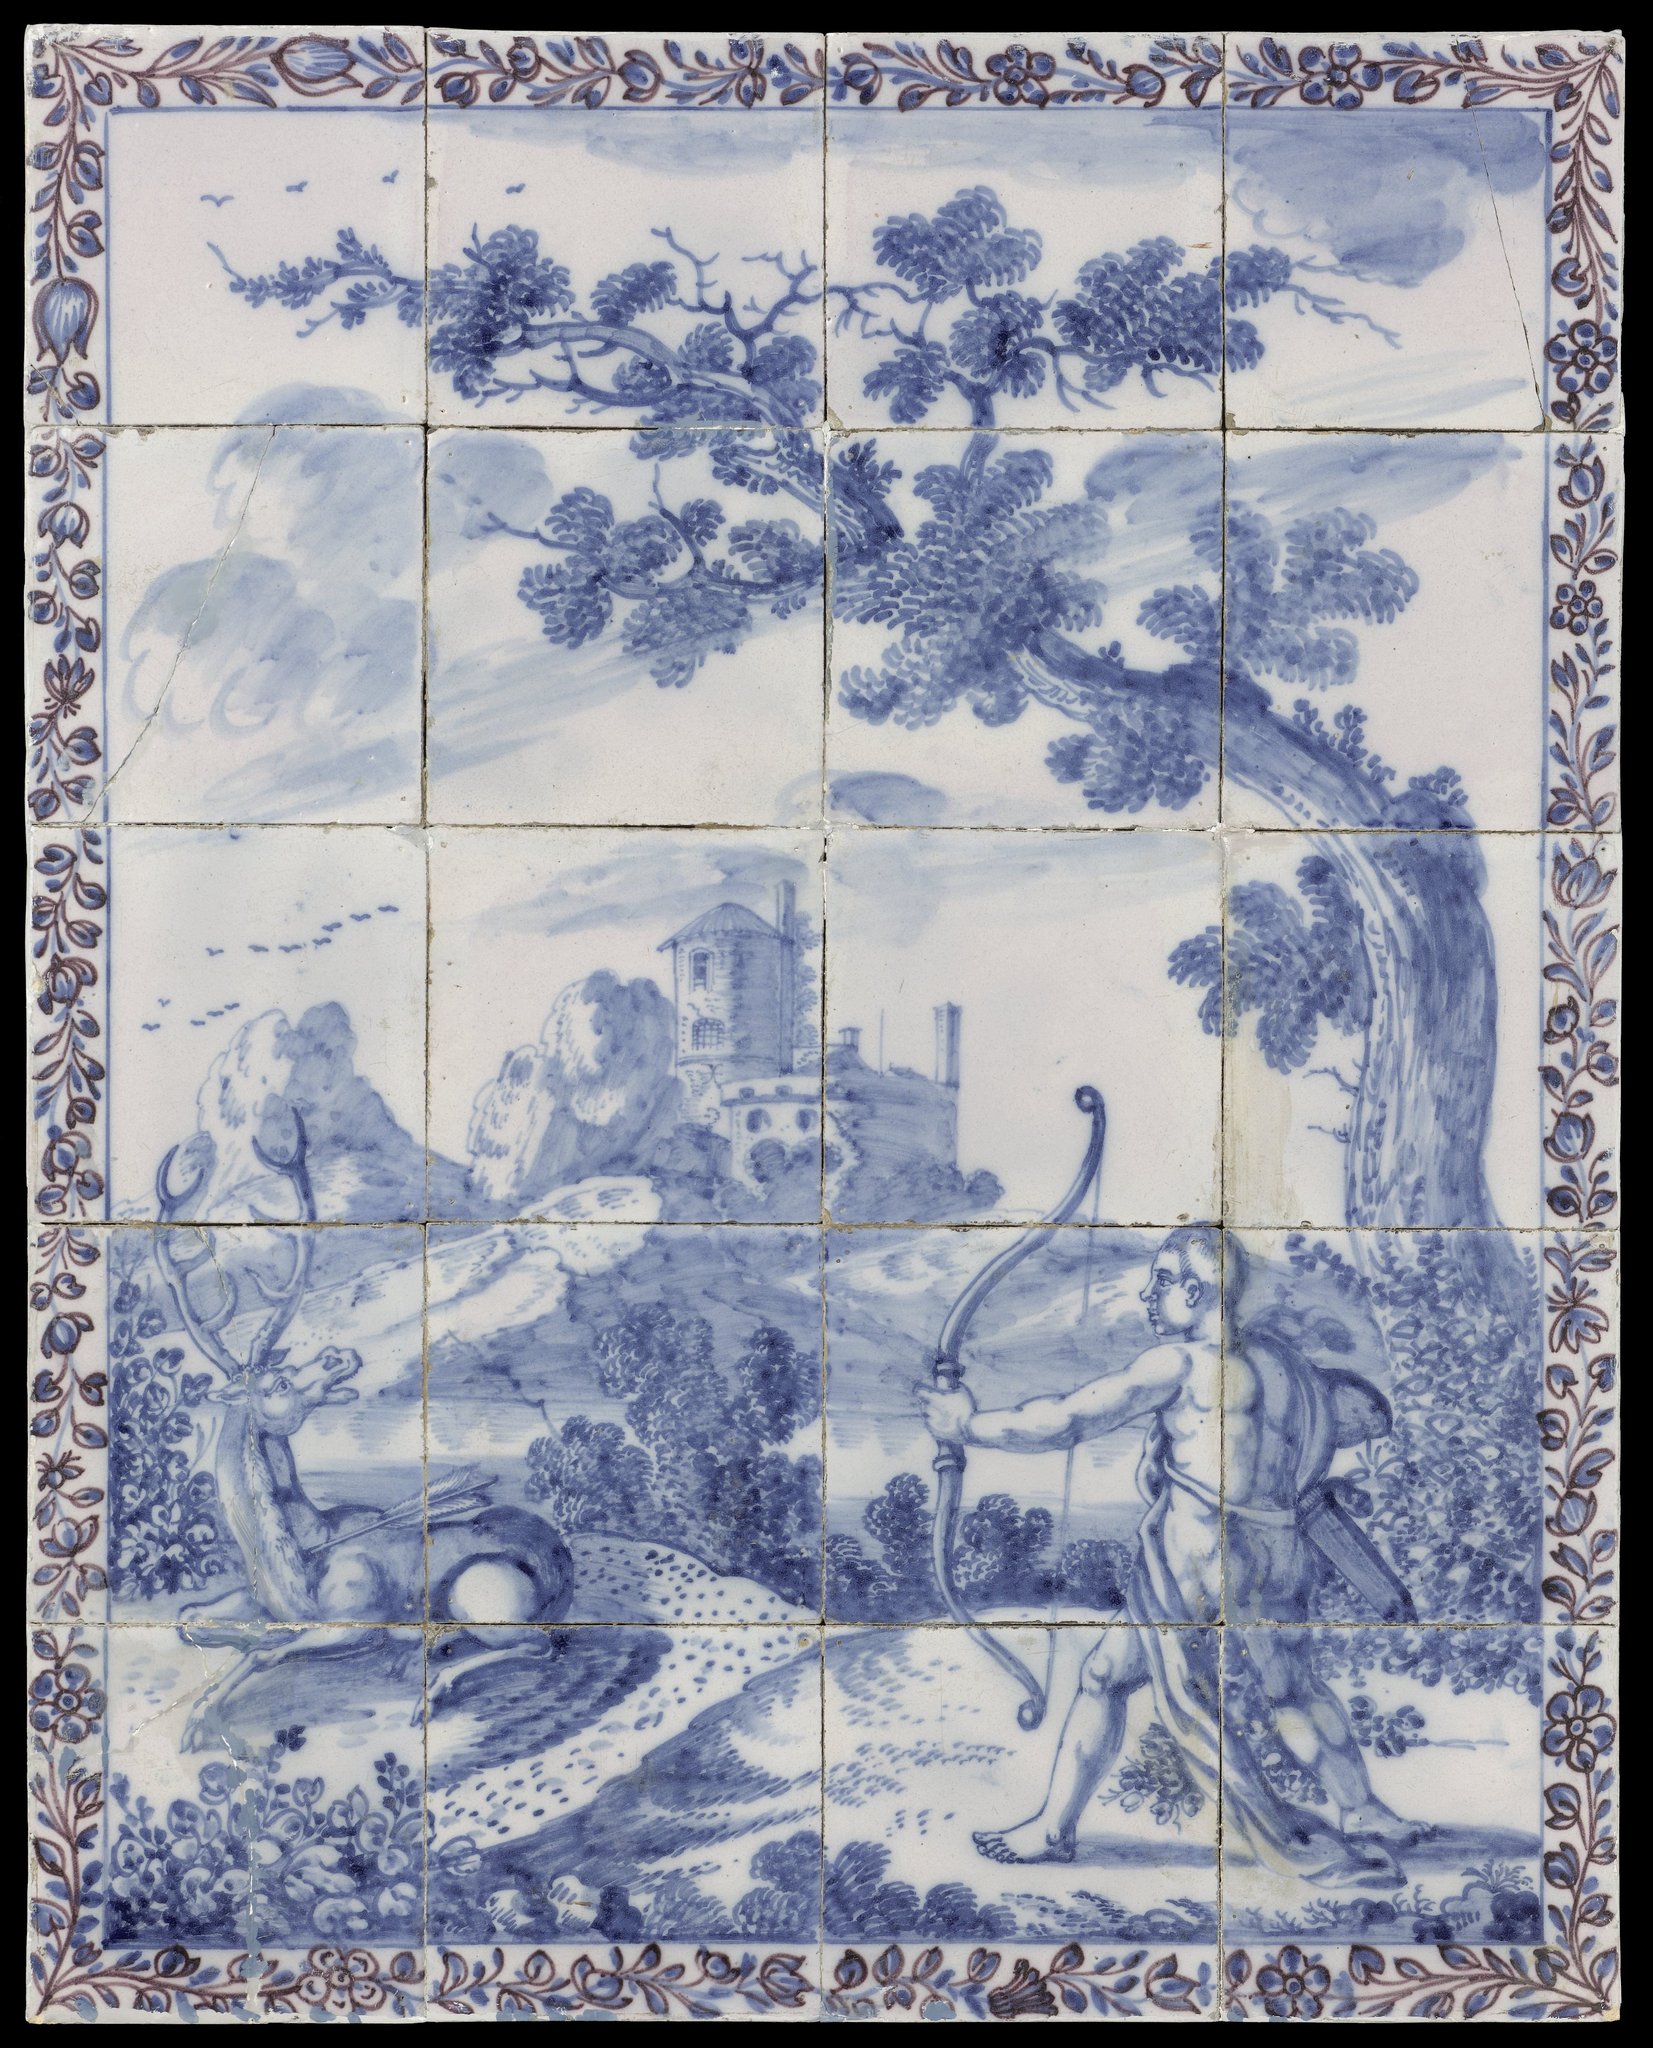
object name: tile tableau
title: Tegeltableau met in blauw een landschap met mythologische voorstelling: Cyparissus verandert in een cypres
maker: Anonymous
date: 1720-1760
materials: earthenware, glaze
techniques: maiolica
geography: netherlands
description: Tegeltableau van twintig tegels (5 x 4) met een blauw landschap met mythologische voorstelling: Cyparissus verandert in een cypres. Rechts een boom en op de achtergrond een rivier en een kasteel. De omlijsting bestaat uit een bloemrank.